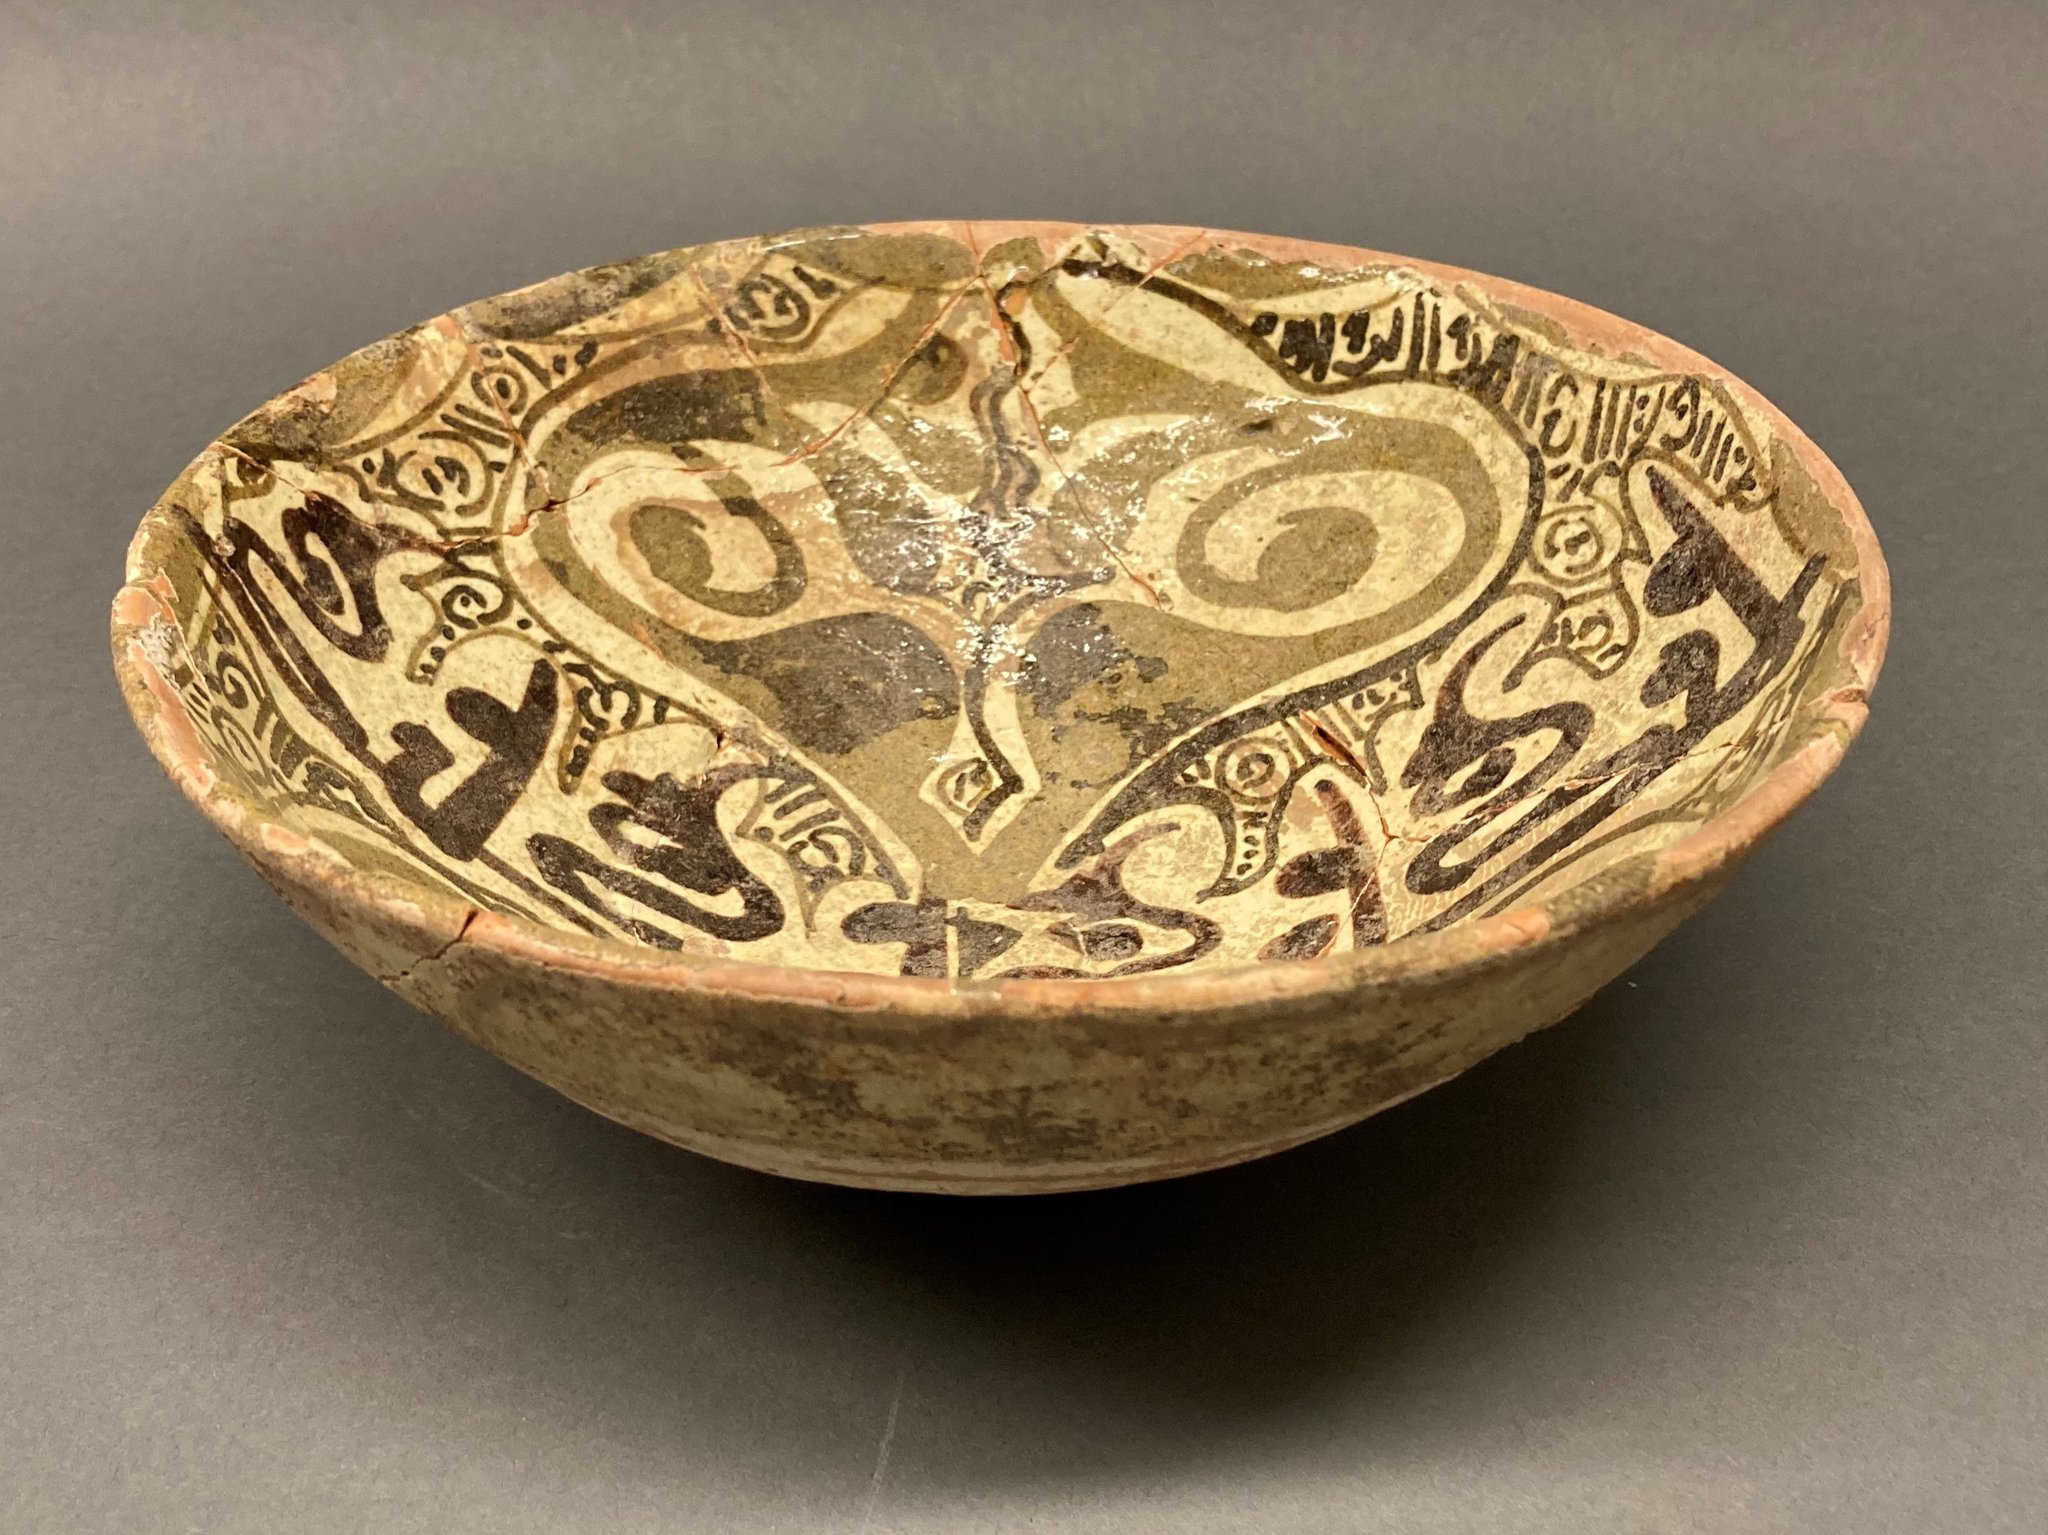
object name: bowl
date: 901-1000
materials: earthenware, glaze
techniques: polychrome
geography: iran